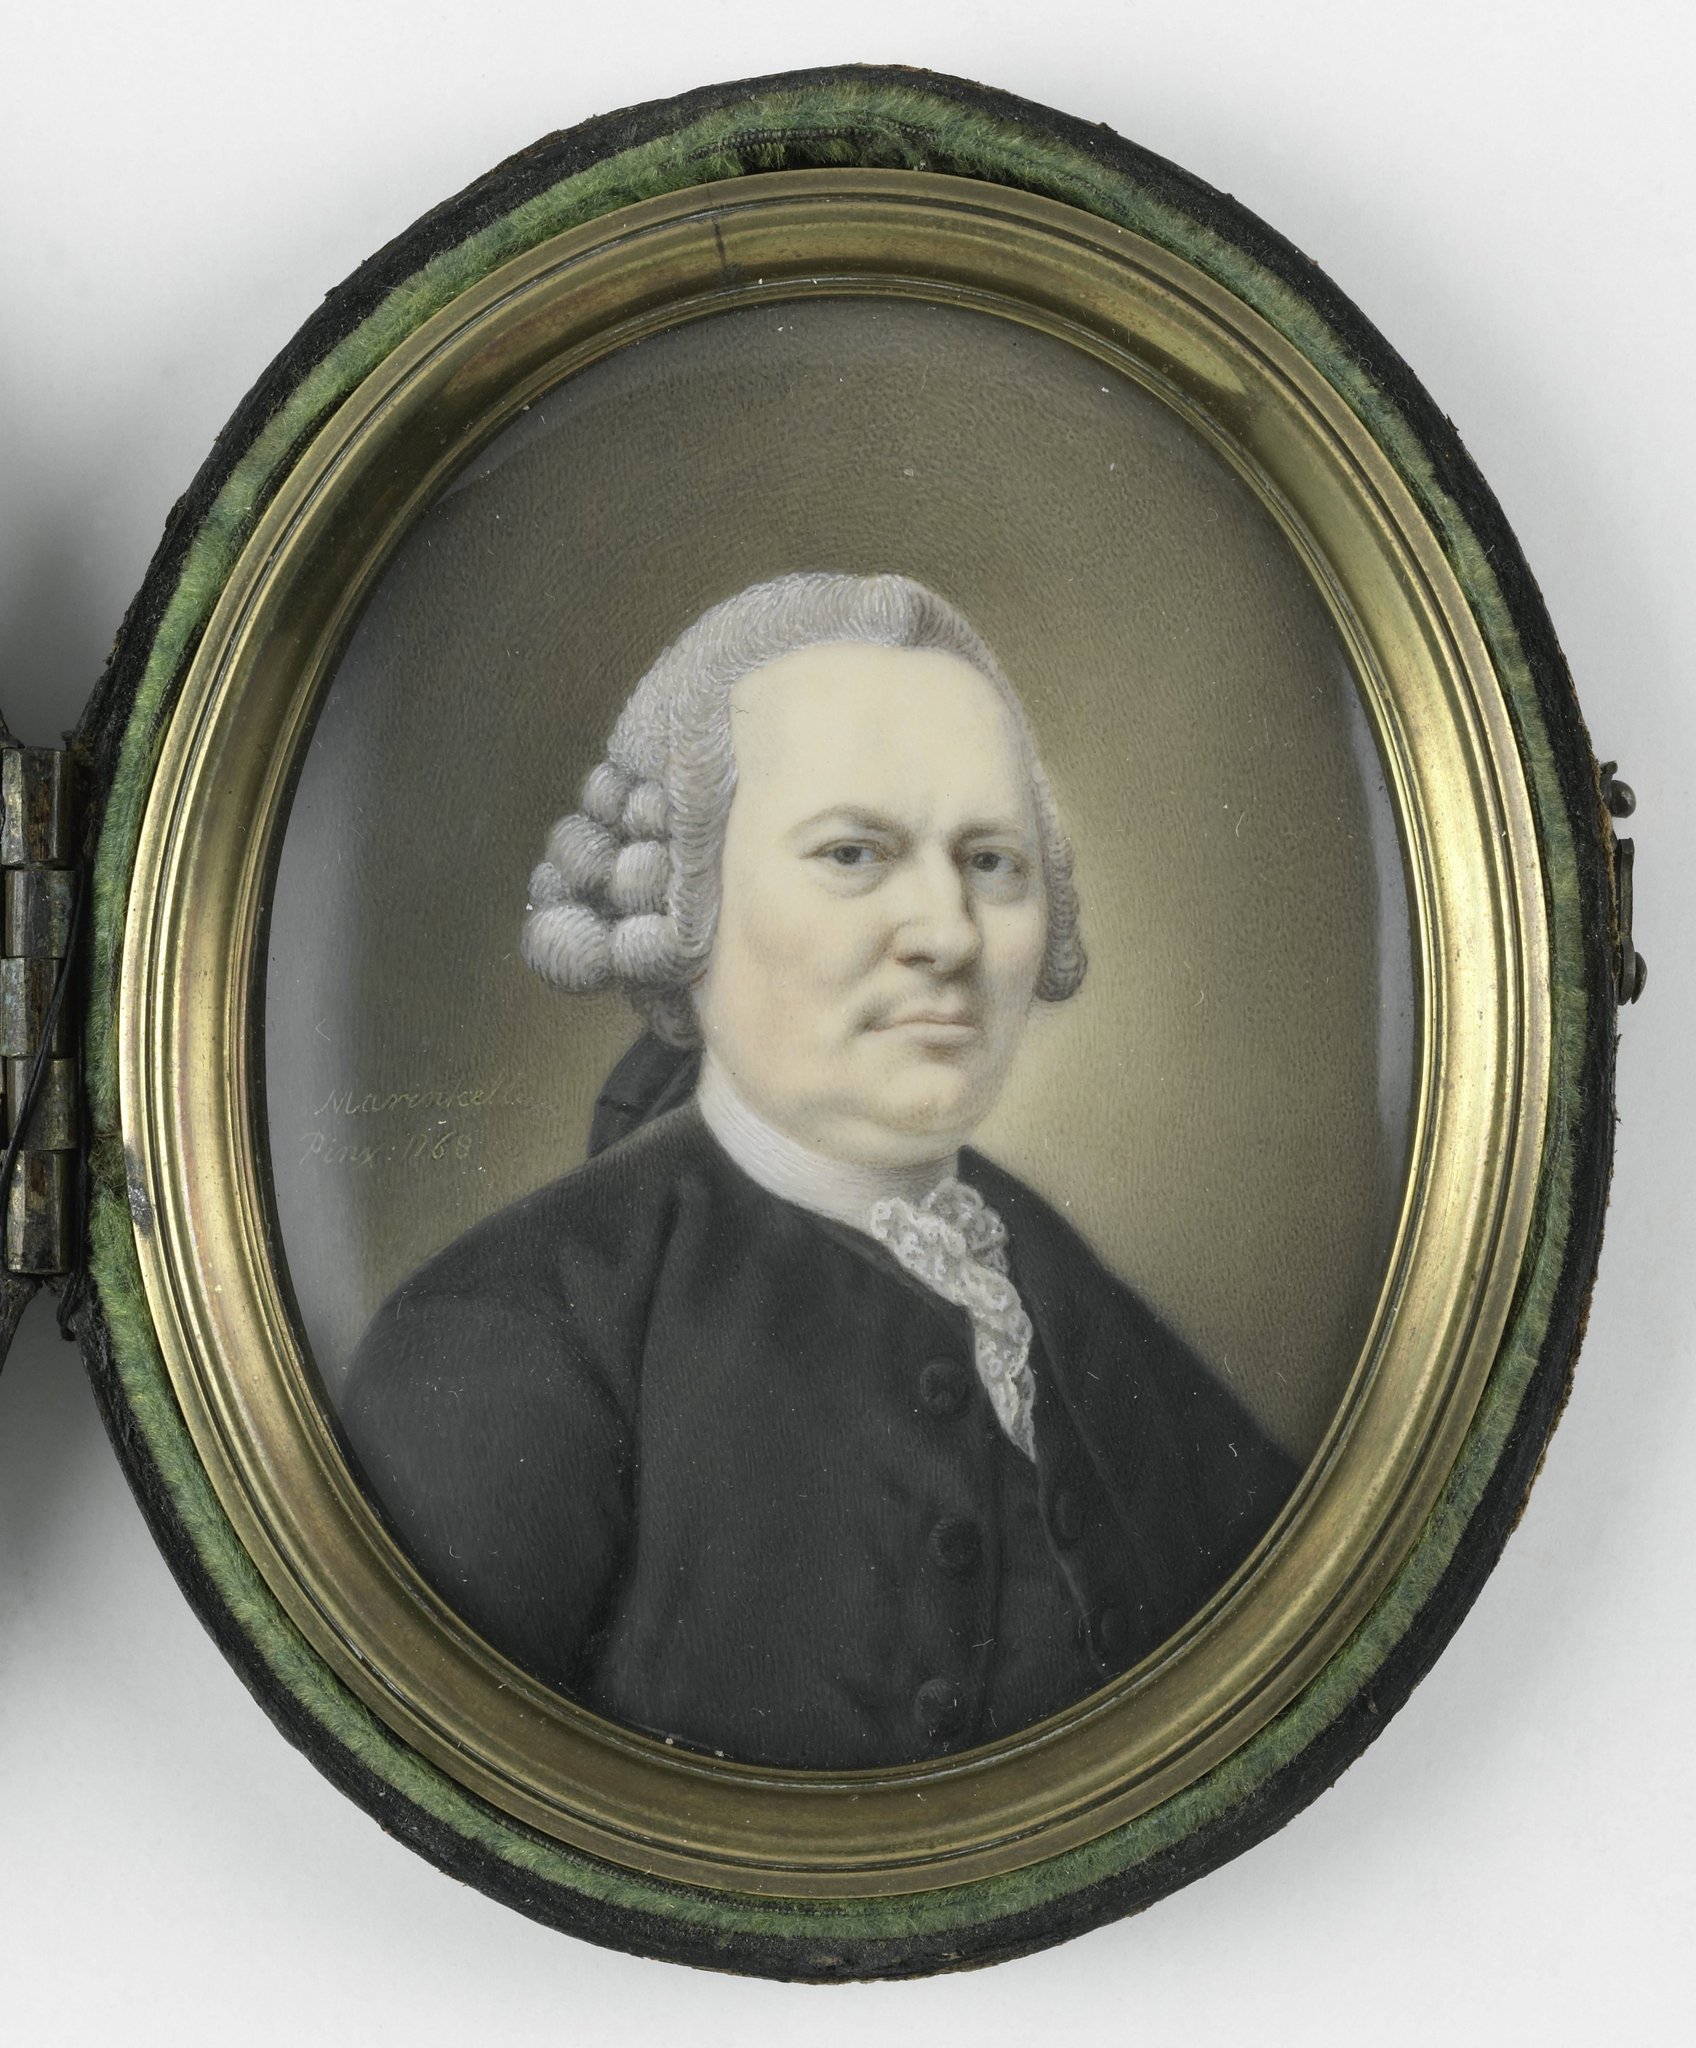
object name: painting, miniature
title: Portret van een man, misschien een lid van de familie Collot d'Escury of Van Rappard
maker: joseph marinkel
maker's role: miniatuurschilder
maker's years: 1732-1782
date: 1768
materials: glass, ivory, leather, metal, textile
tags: anonymous historical person portrayed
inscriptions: signature and date: ‘Marinkelle Pinx: 1768’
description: Joseph Marinkelle (1732 - 1782). Portrait of a man. Ivory,in a case of rayskin, lined with green velvet, 1768. Given by Jonkheer J.C. Martens van Sevenhoven, Almen 1972.